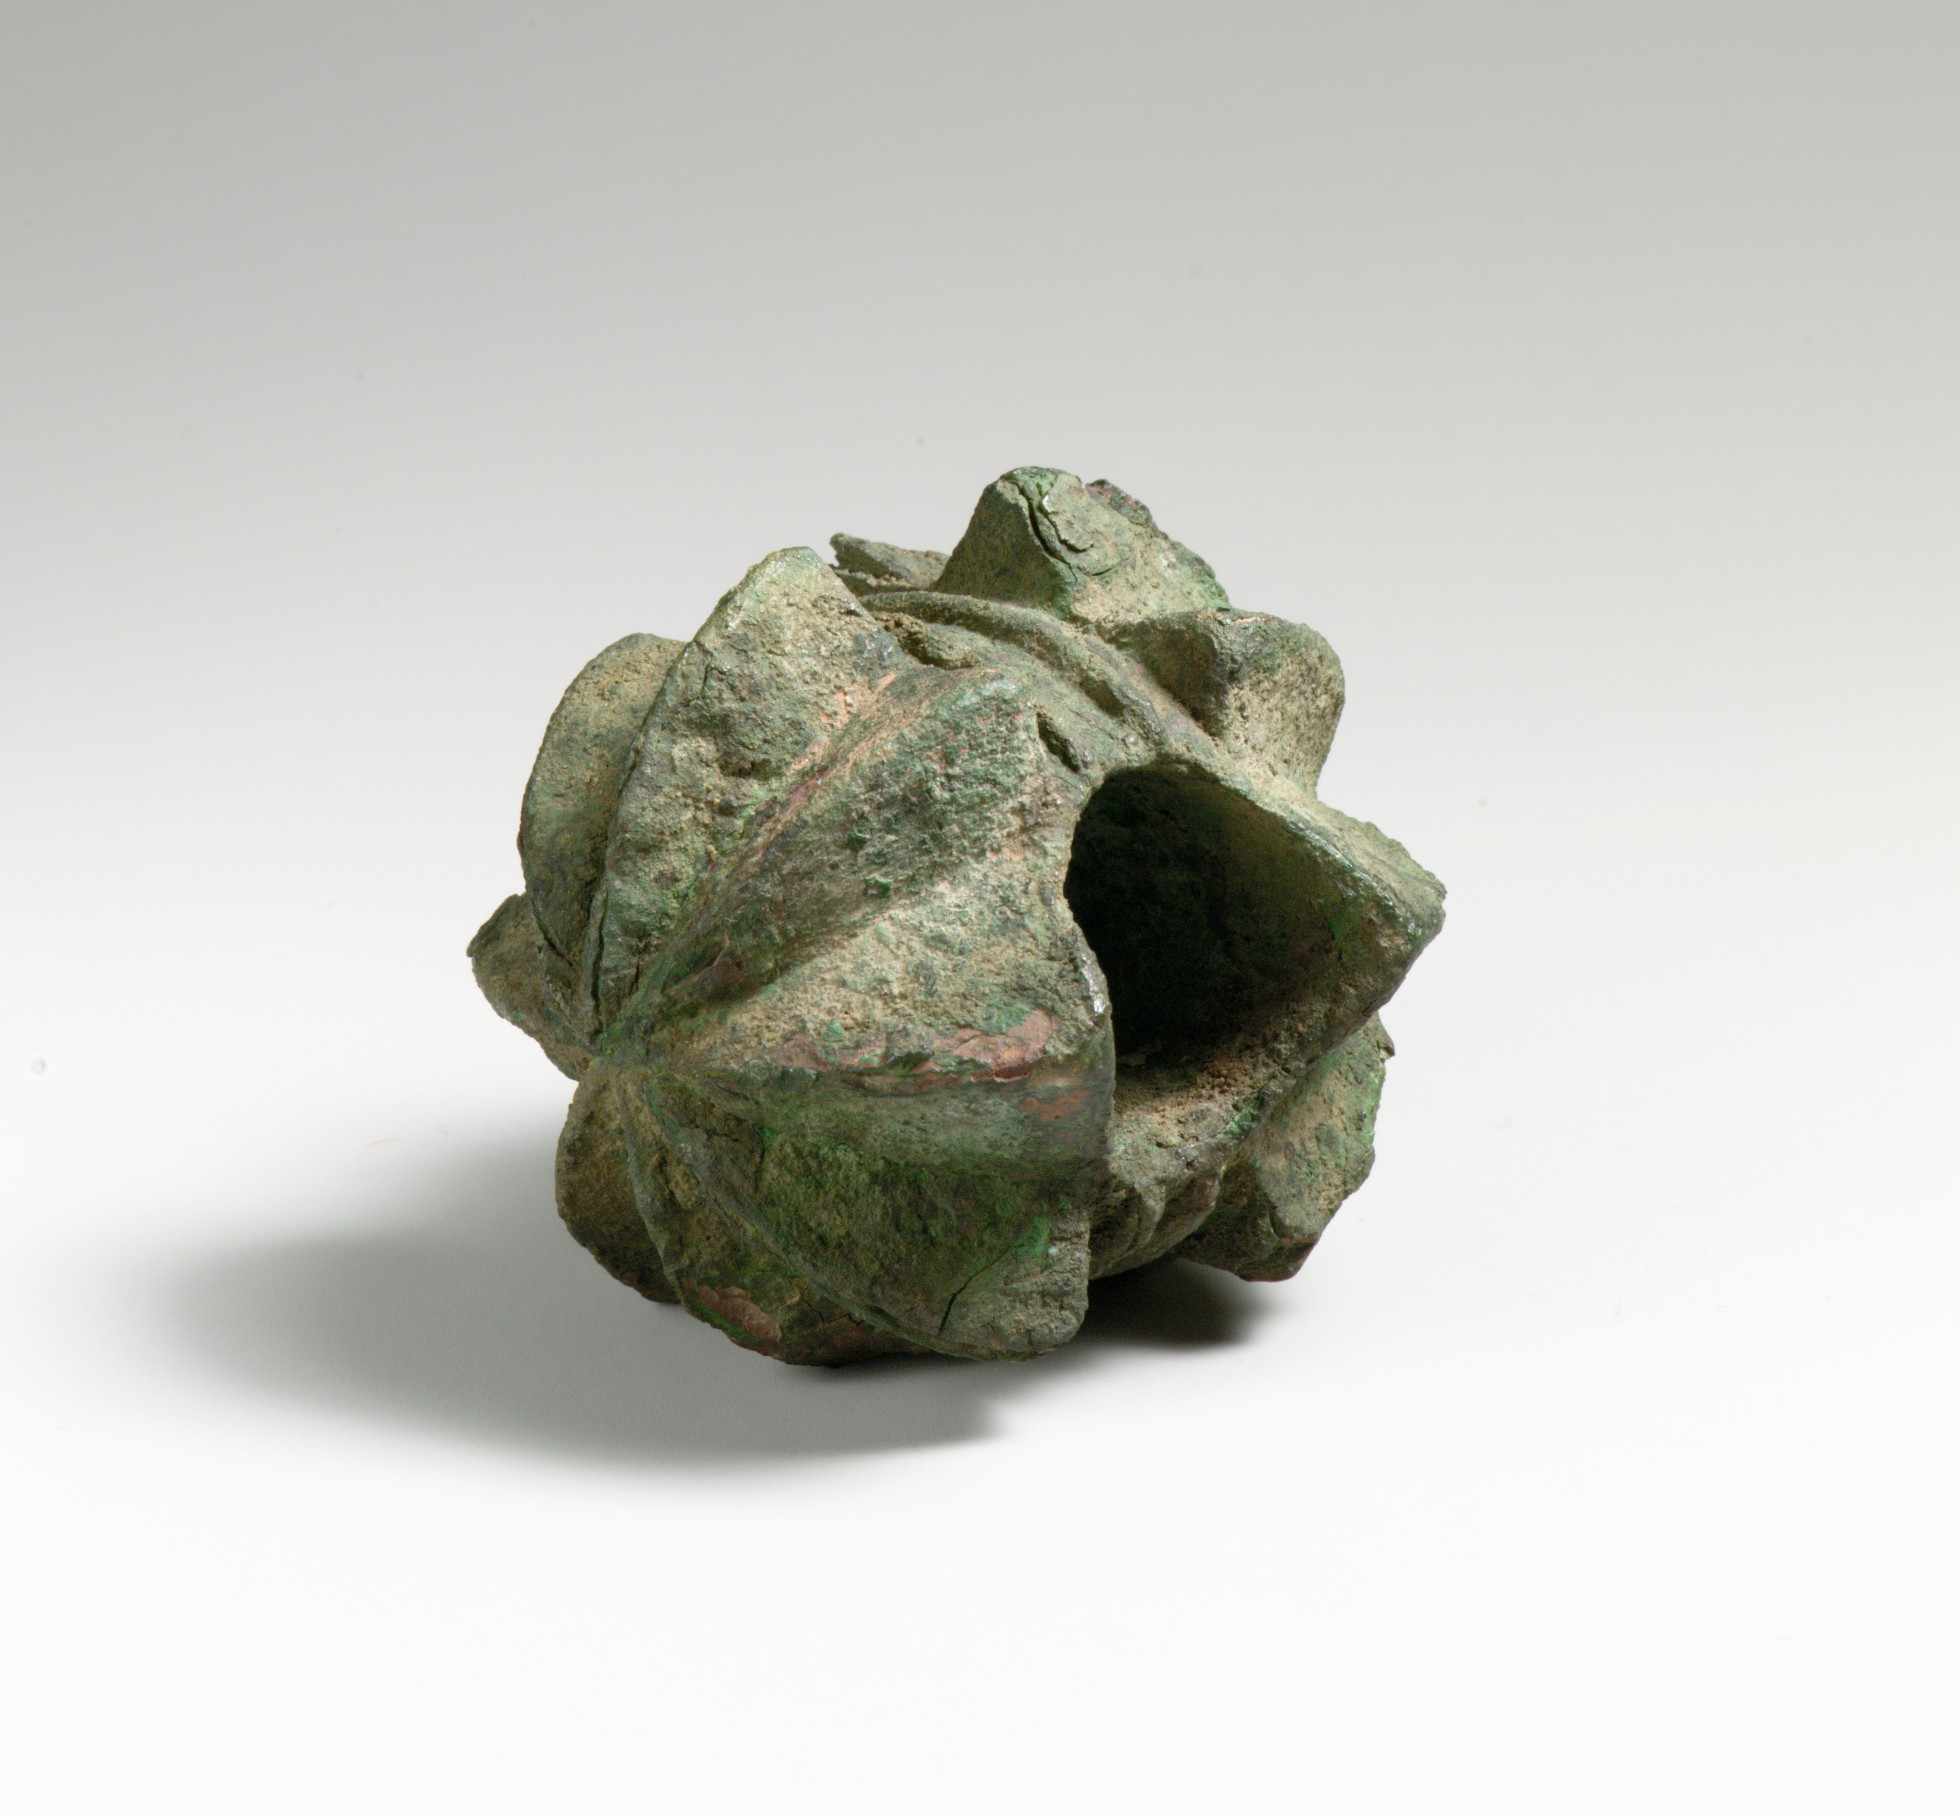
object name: mace head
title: Bronze mace head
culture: cypriot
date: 800-701 BCE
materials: bronze